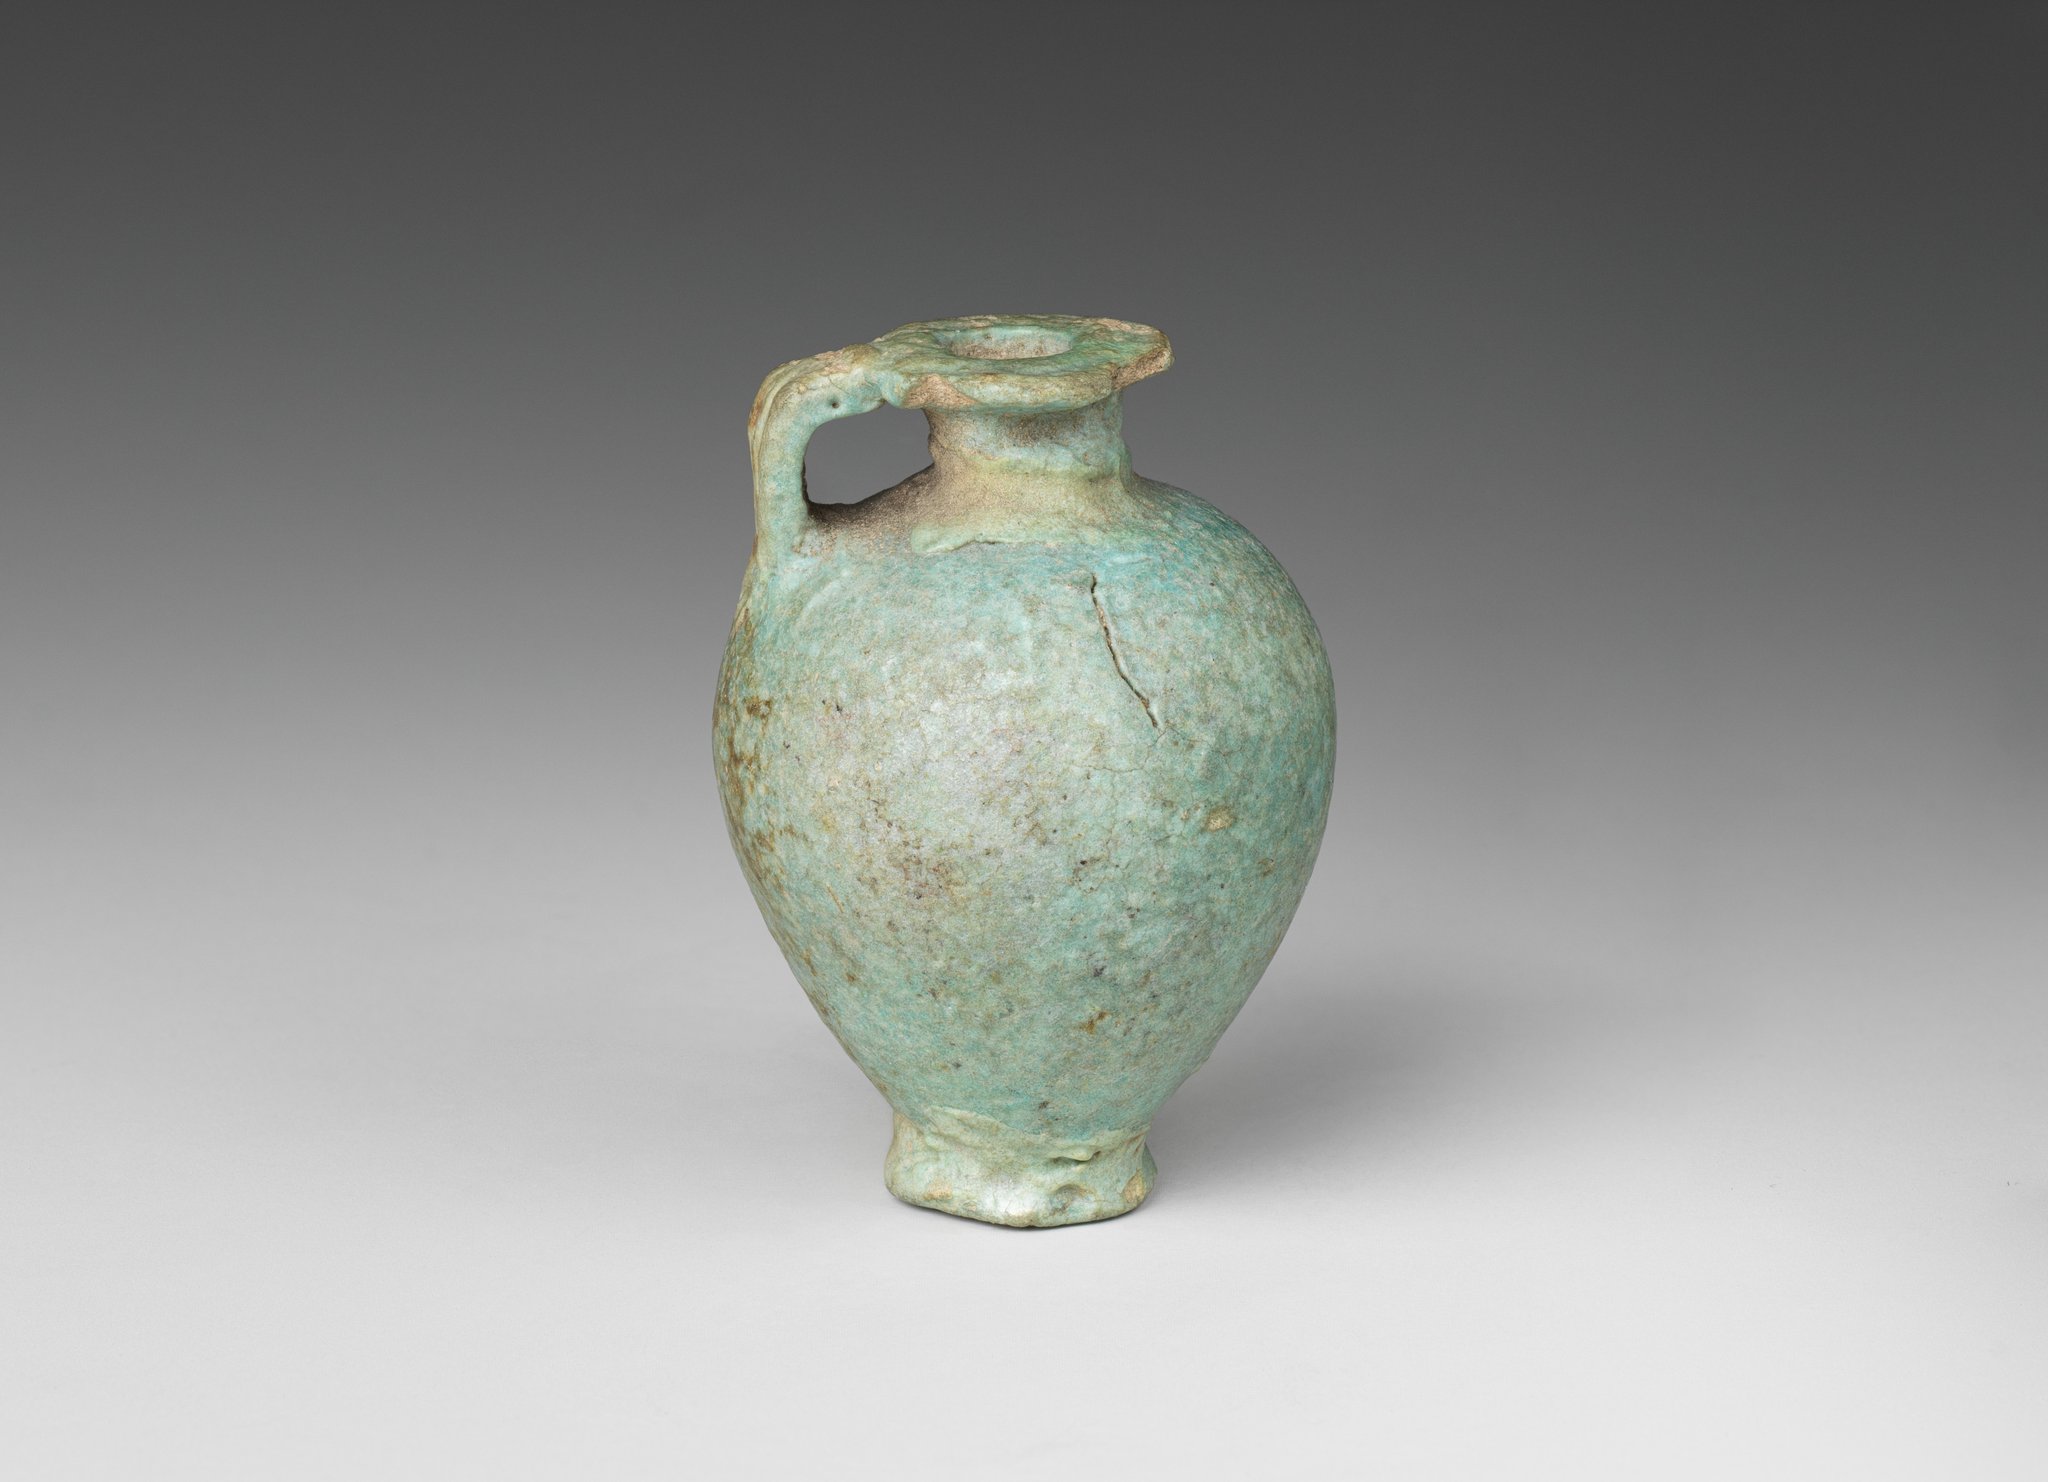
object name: jug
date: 664-332 BCE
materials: faience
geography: egypt